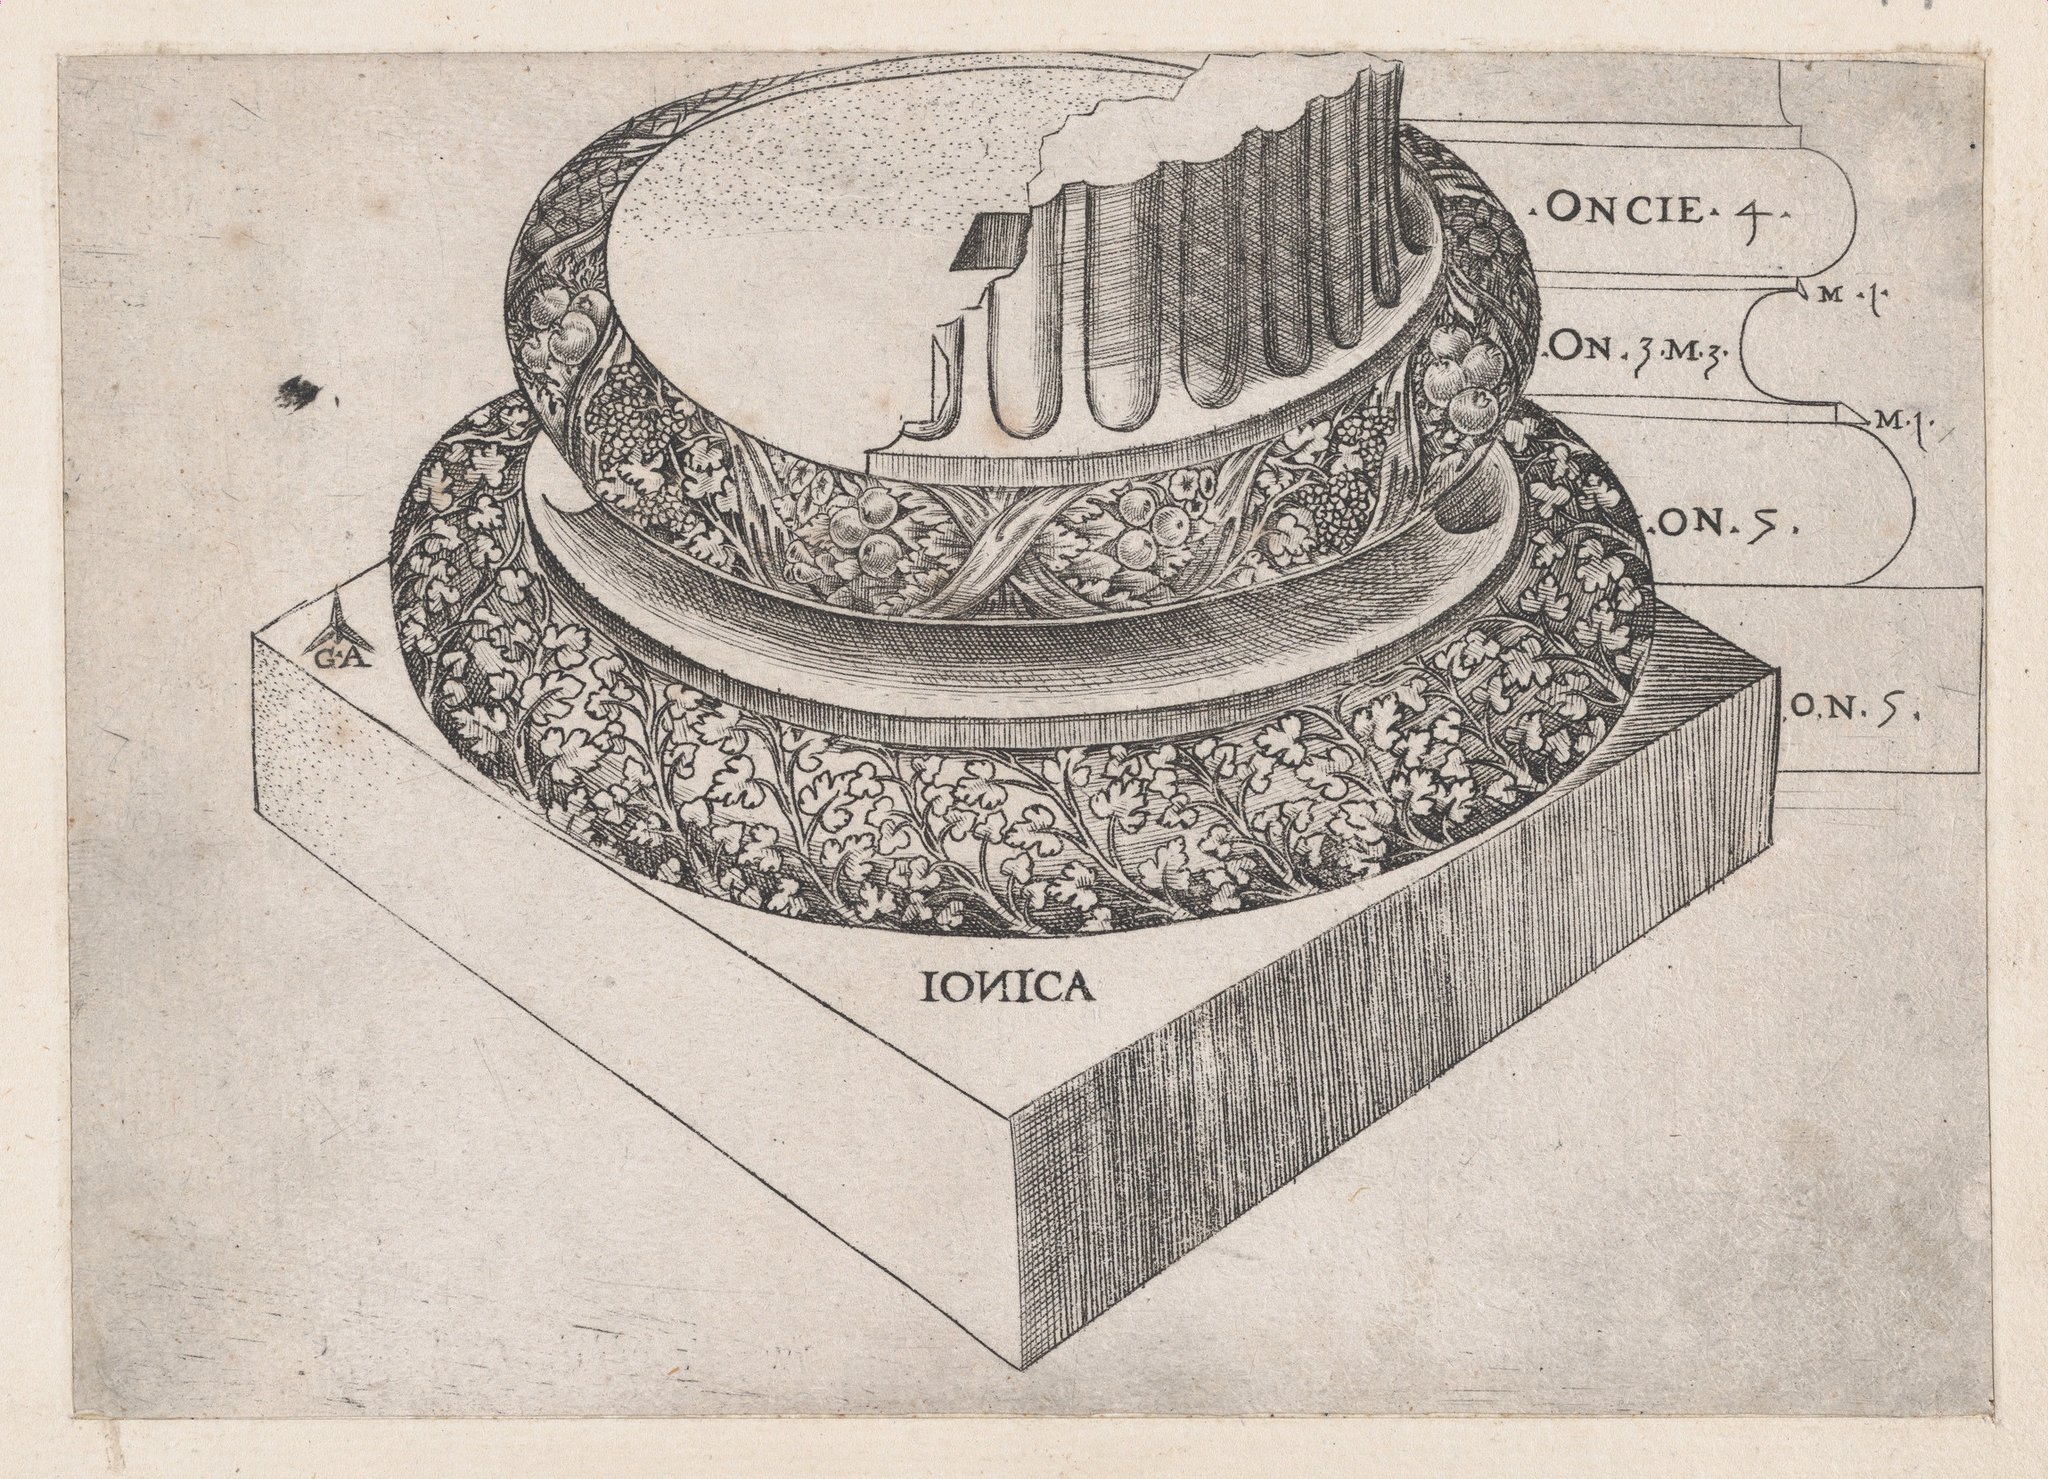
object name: print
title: Ionic base, from "Speculum Romanae Magnificentiae"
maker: monogrammist g.a. with the caltrop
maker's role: artist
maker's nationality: italian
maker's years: 1535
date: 1537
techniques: engraving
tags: architecture,leaves